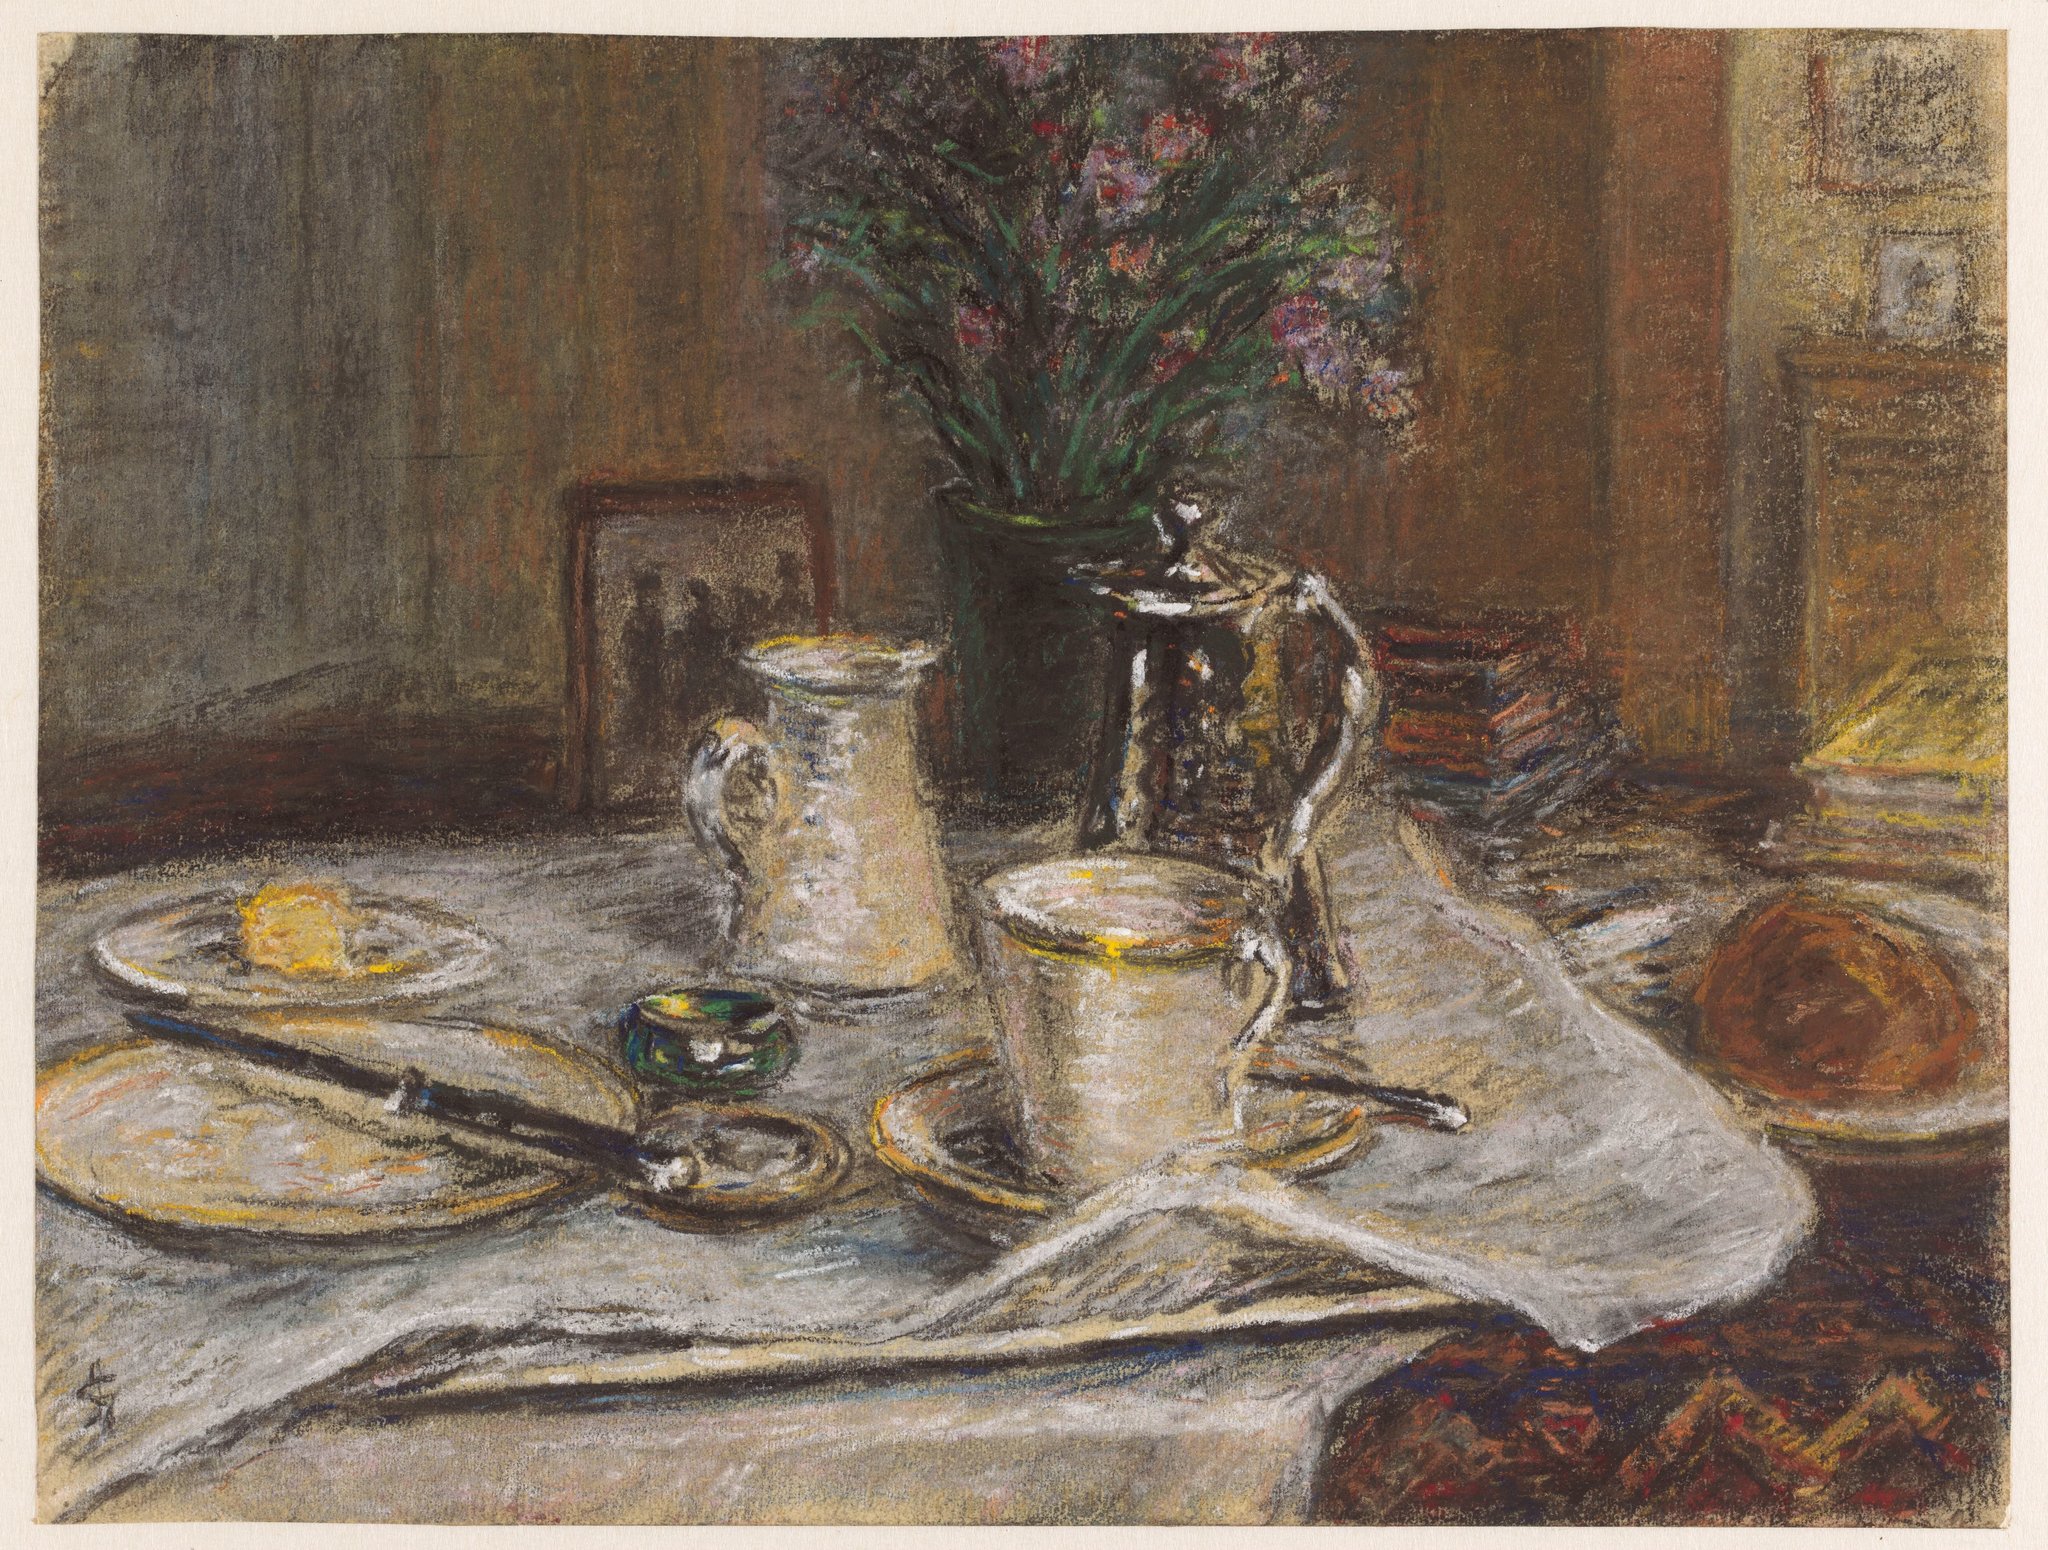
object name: drawing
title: Ontbijt, provisorisch gedekte tafel in woonvertrek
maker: carel nicolaas storm van s-gravesande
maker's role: draughtsman, print maker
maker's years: 1841-1924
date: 1915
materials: chalk, paper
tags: breakfast piece (dutch: 'ontbijtje'), germany